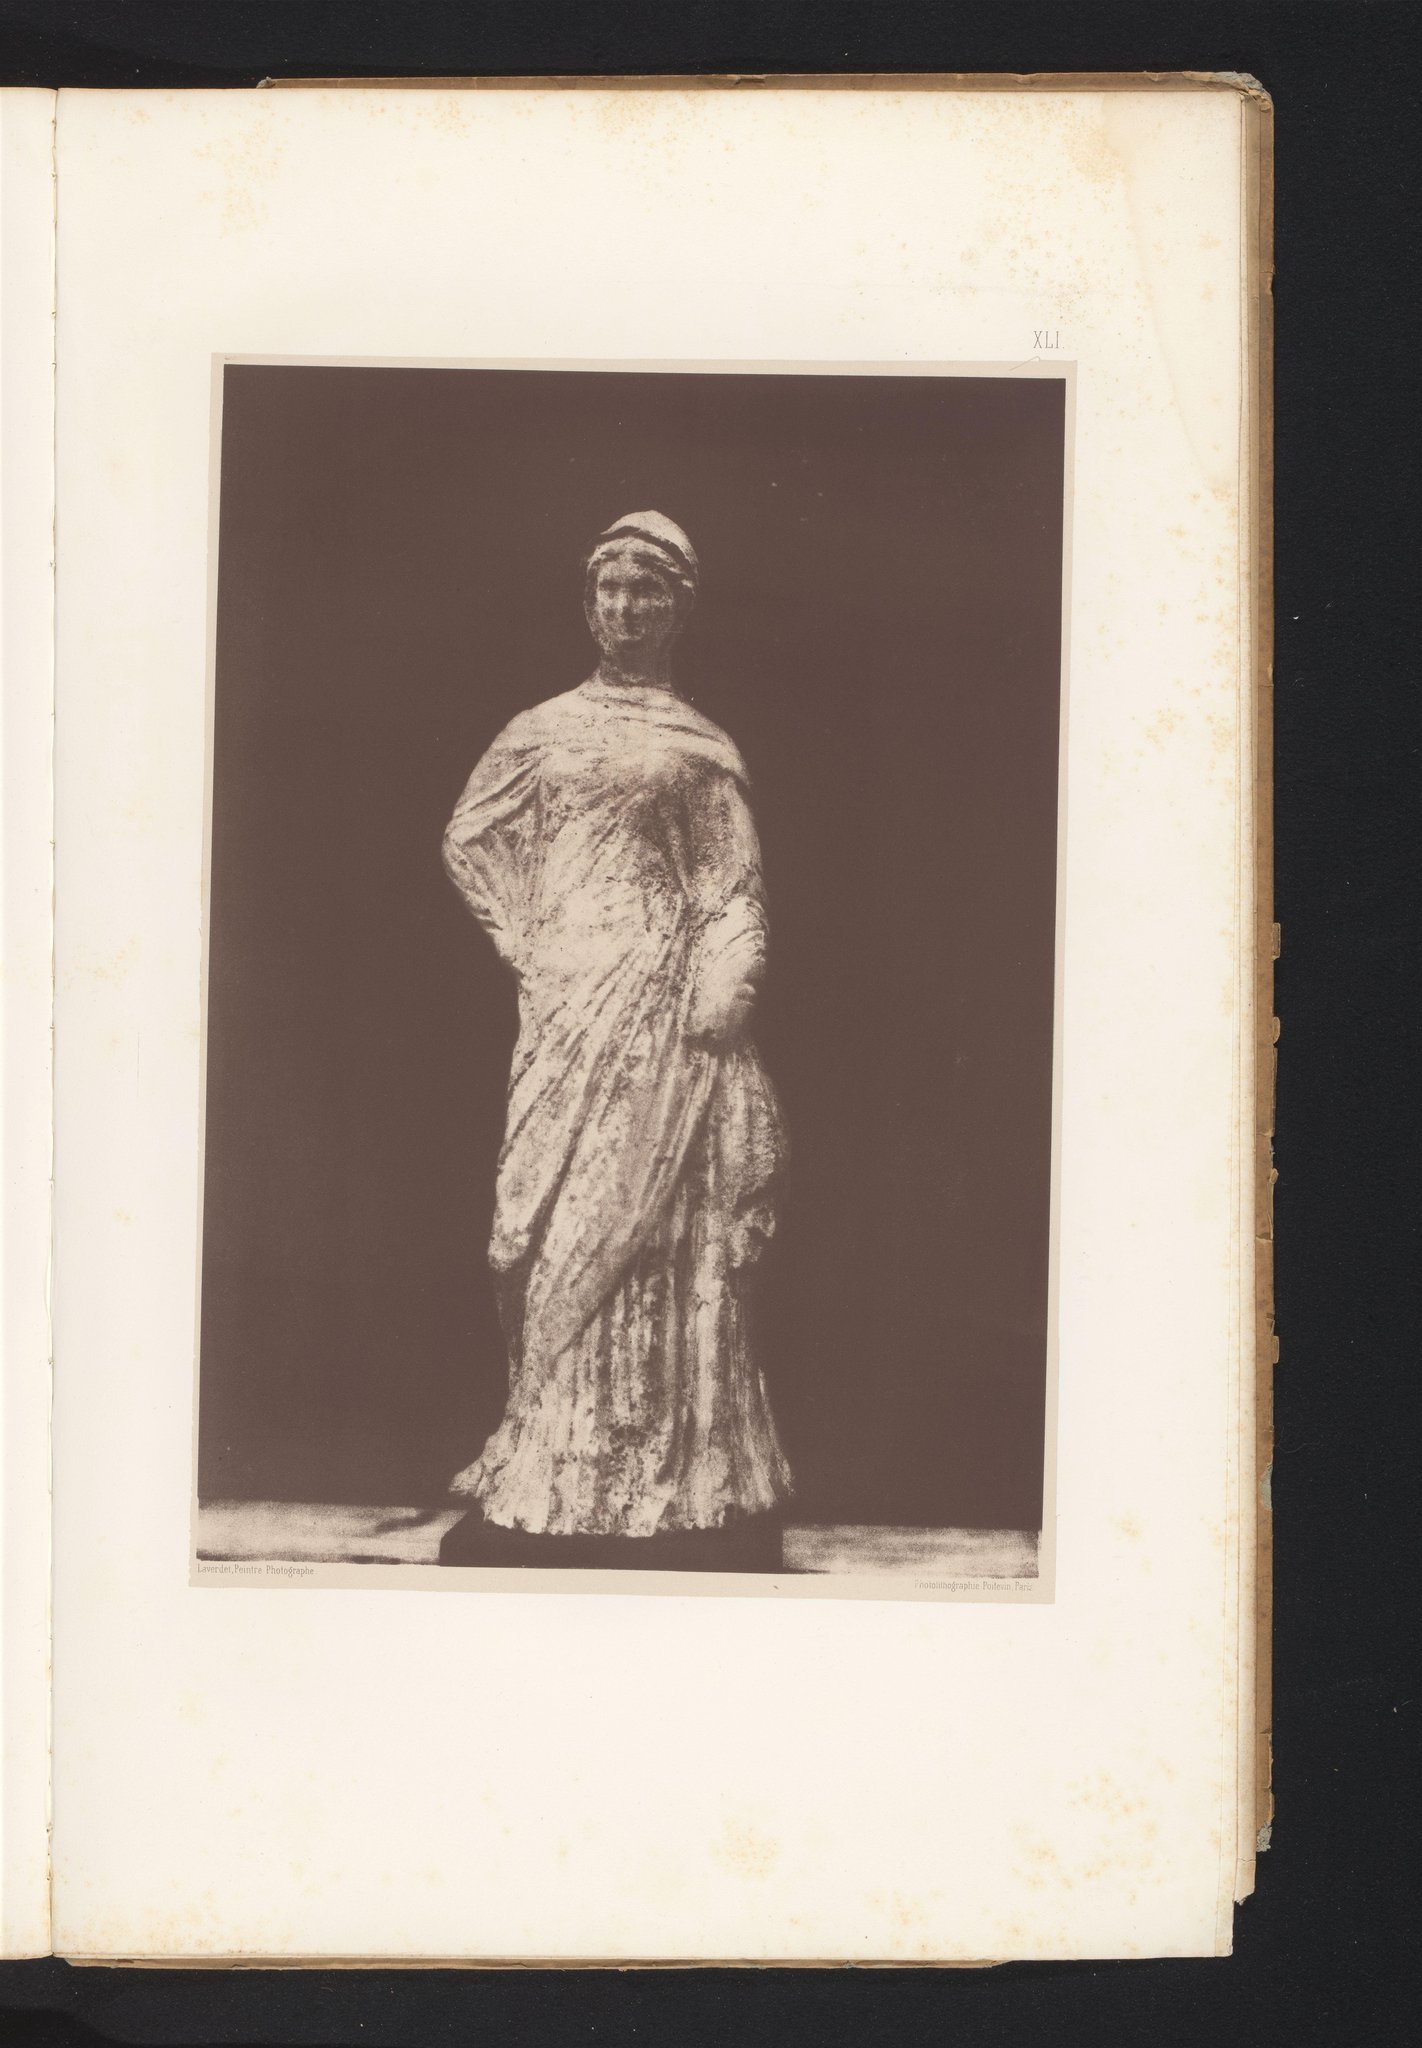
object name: page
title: Terracotta sculptuur van Mnemosyne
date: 1852-1857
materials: paper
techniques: photolithography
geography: paris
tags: mnemosyne, piece of sculpture, reproduction of a piece of sculpture (+ clay, sand, etc. ~ arts)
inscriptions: number: ‘XLI.’